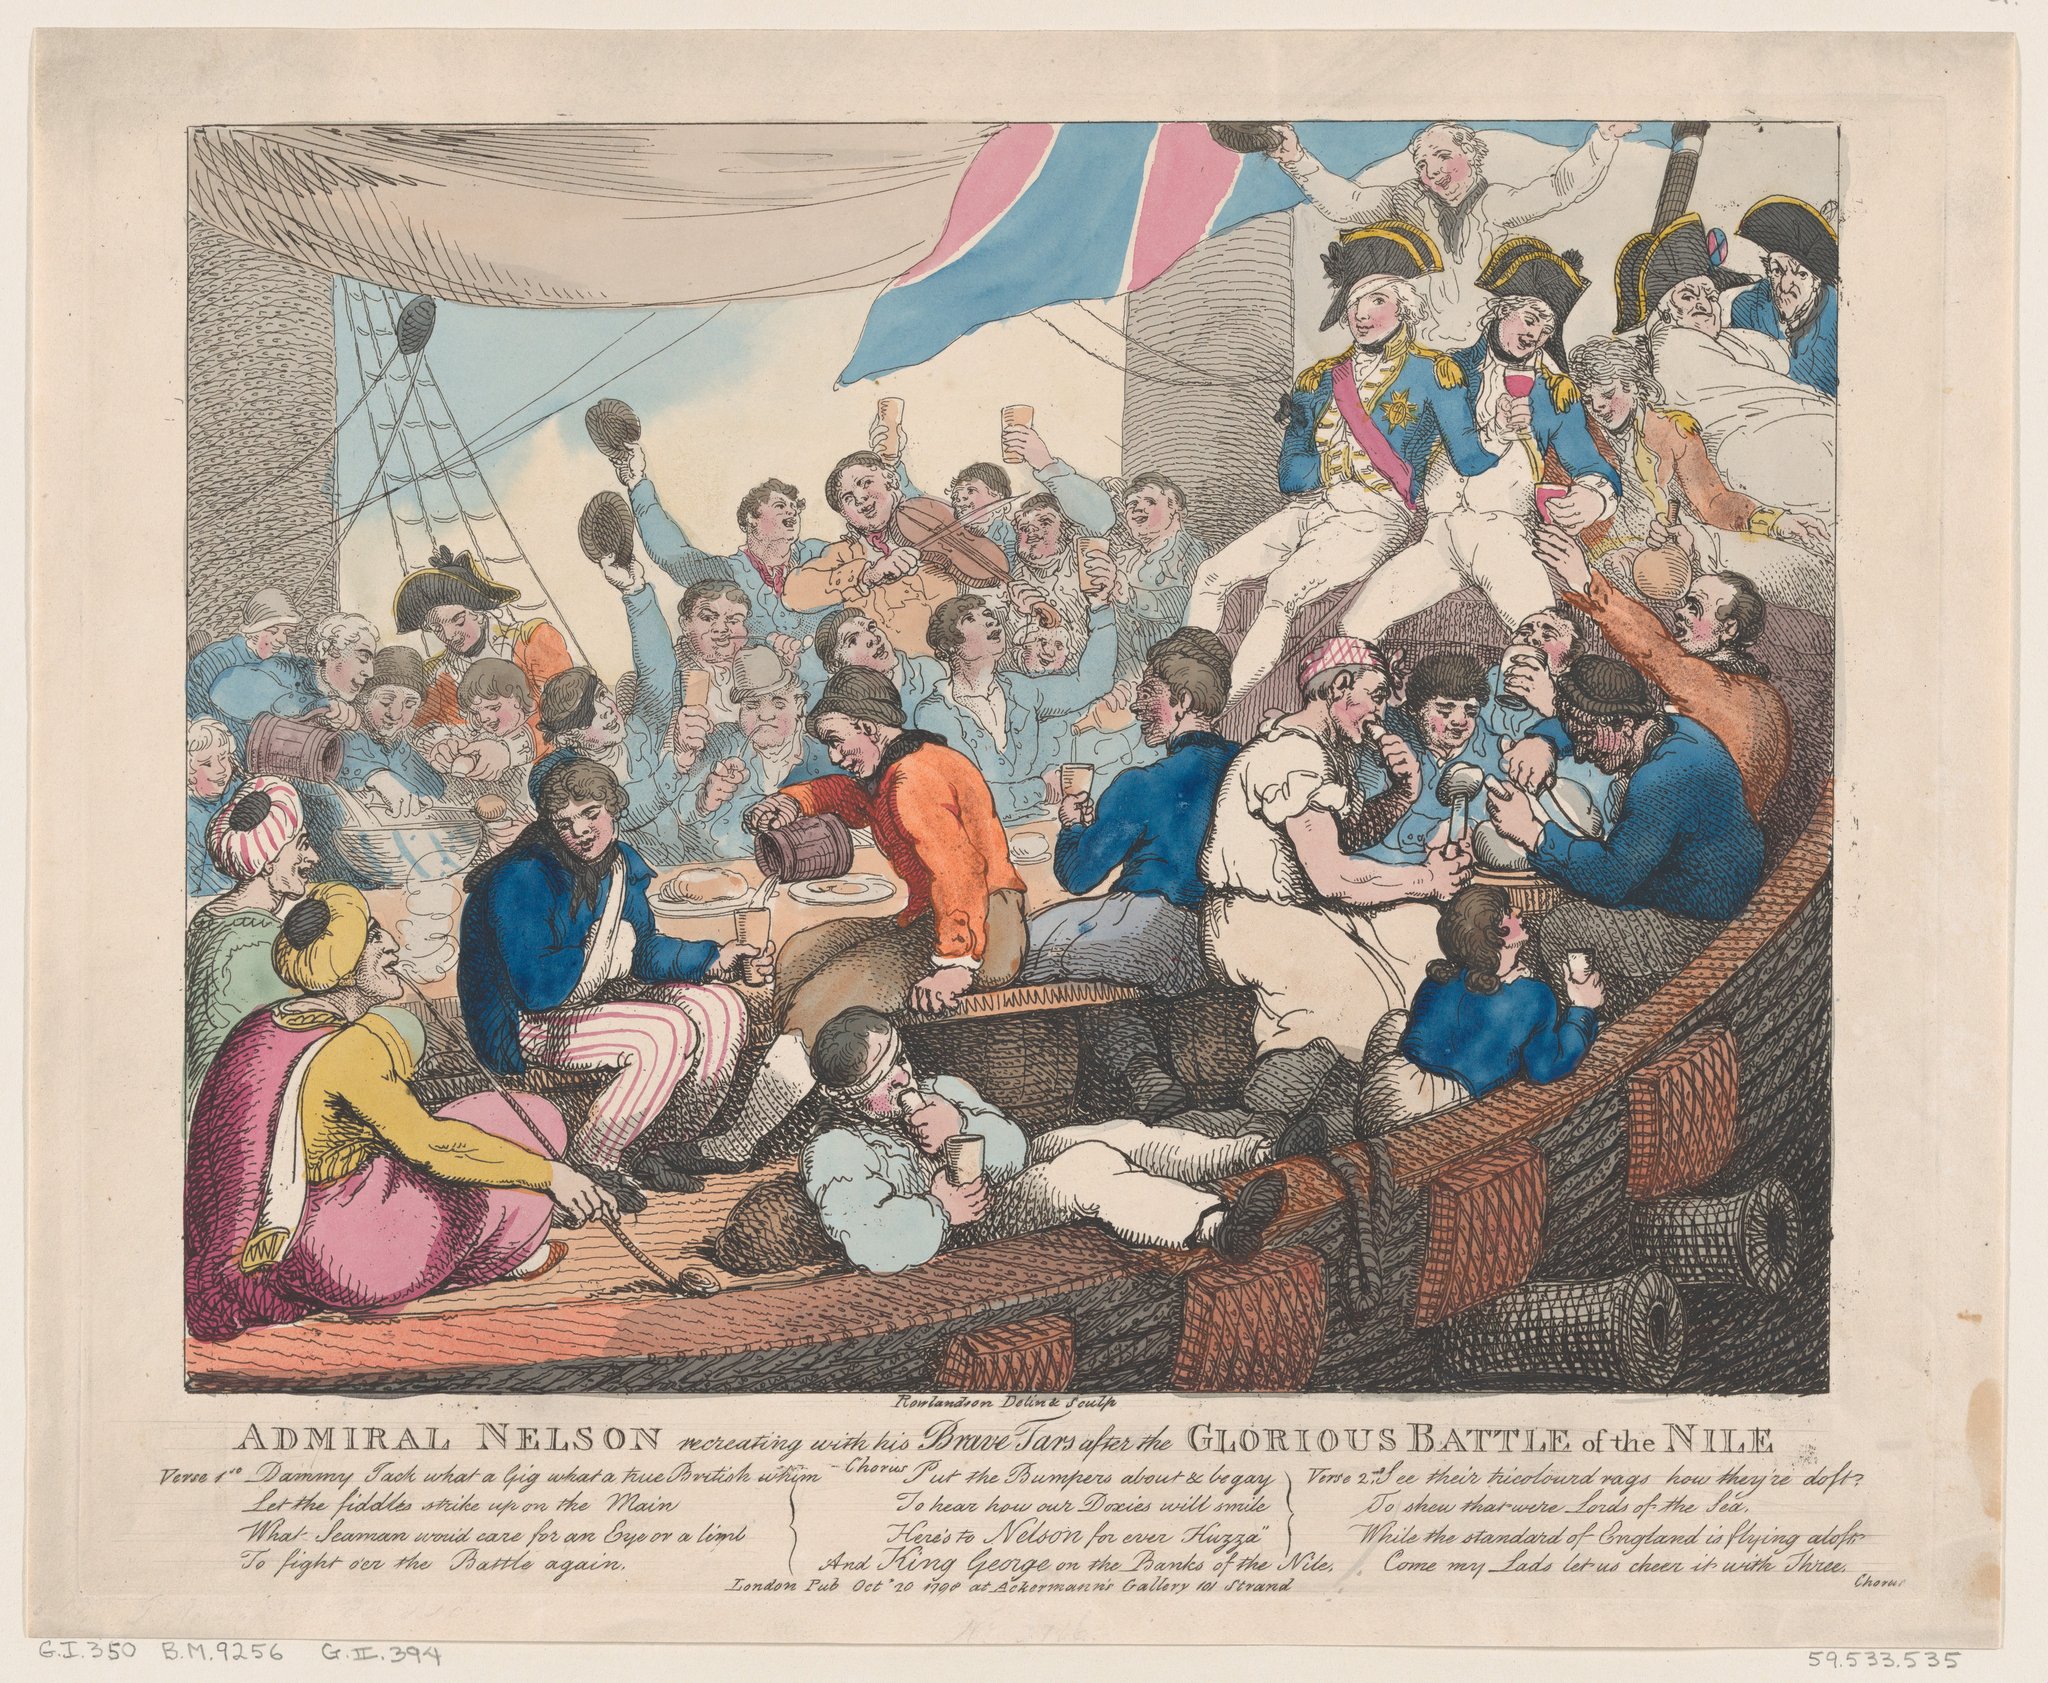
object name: print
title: Admiral Nelson Recreating with his Brave Tars after the Glorious Battle of the Nile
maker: thomas rowlandson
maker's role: artist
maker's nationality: british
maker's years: 1757-1827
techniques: aquatint, etching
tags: men,admirals,ships